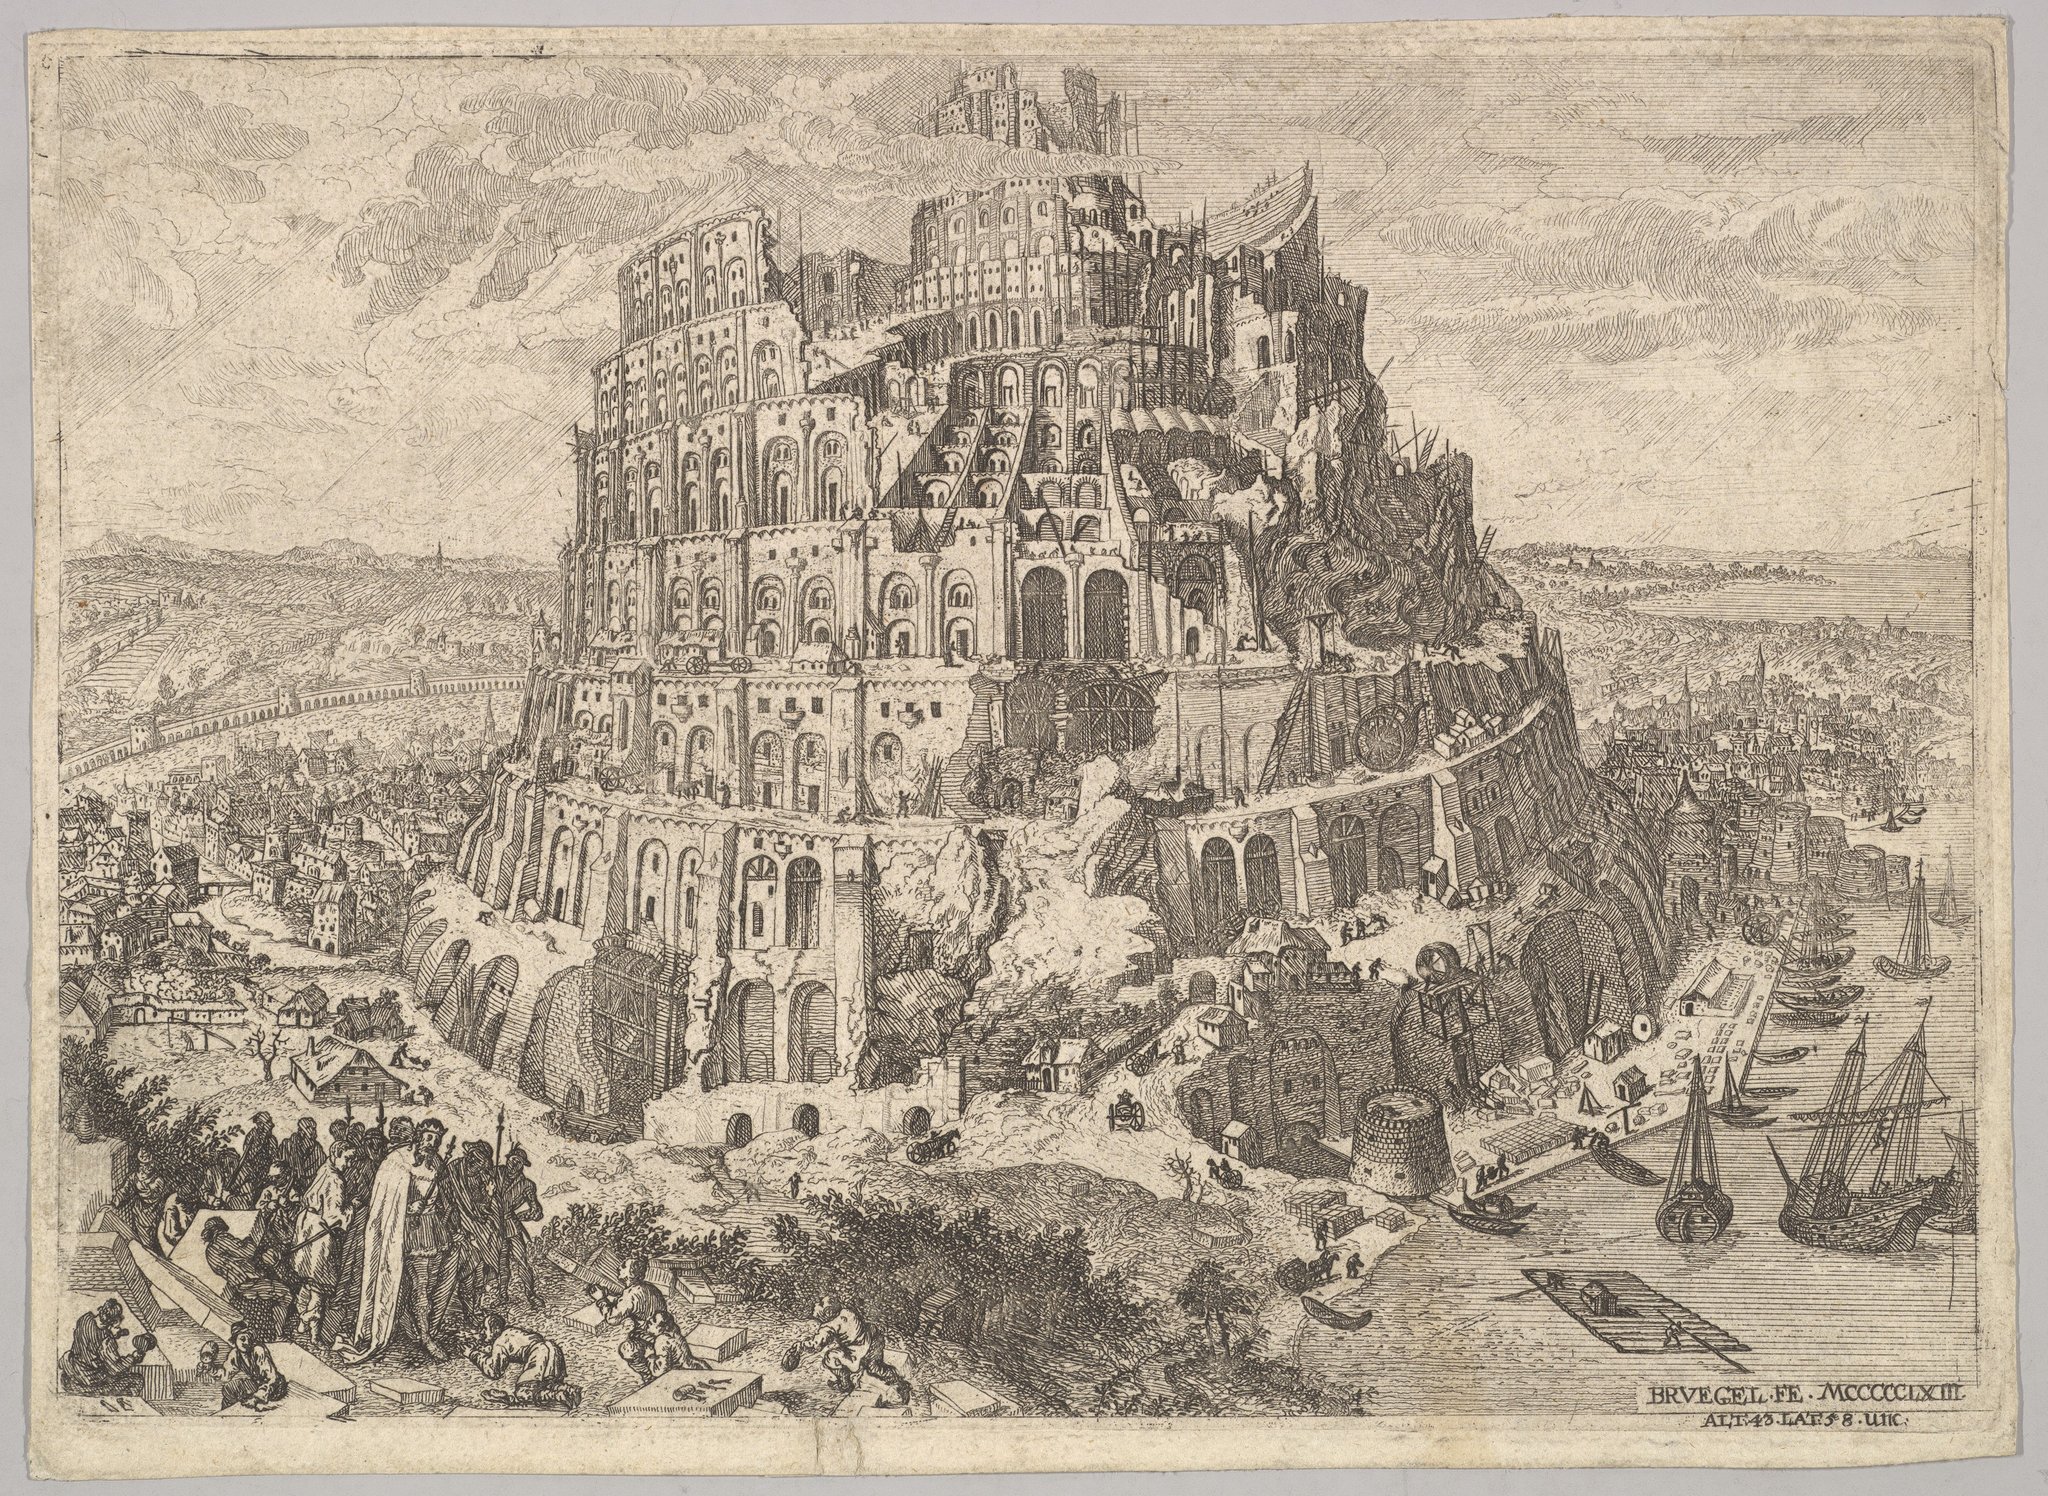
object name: print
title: The Tower of Babel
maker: anton joseph von prenner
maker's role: artist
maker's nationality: austrian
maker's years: 1683-1761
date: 1683-1761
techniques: etching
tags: towers,men,landscapes,boats